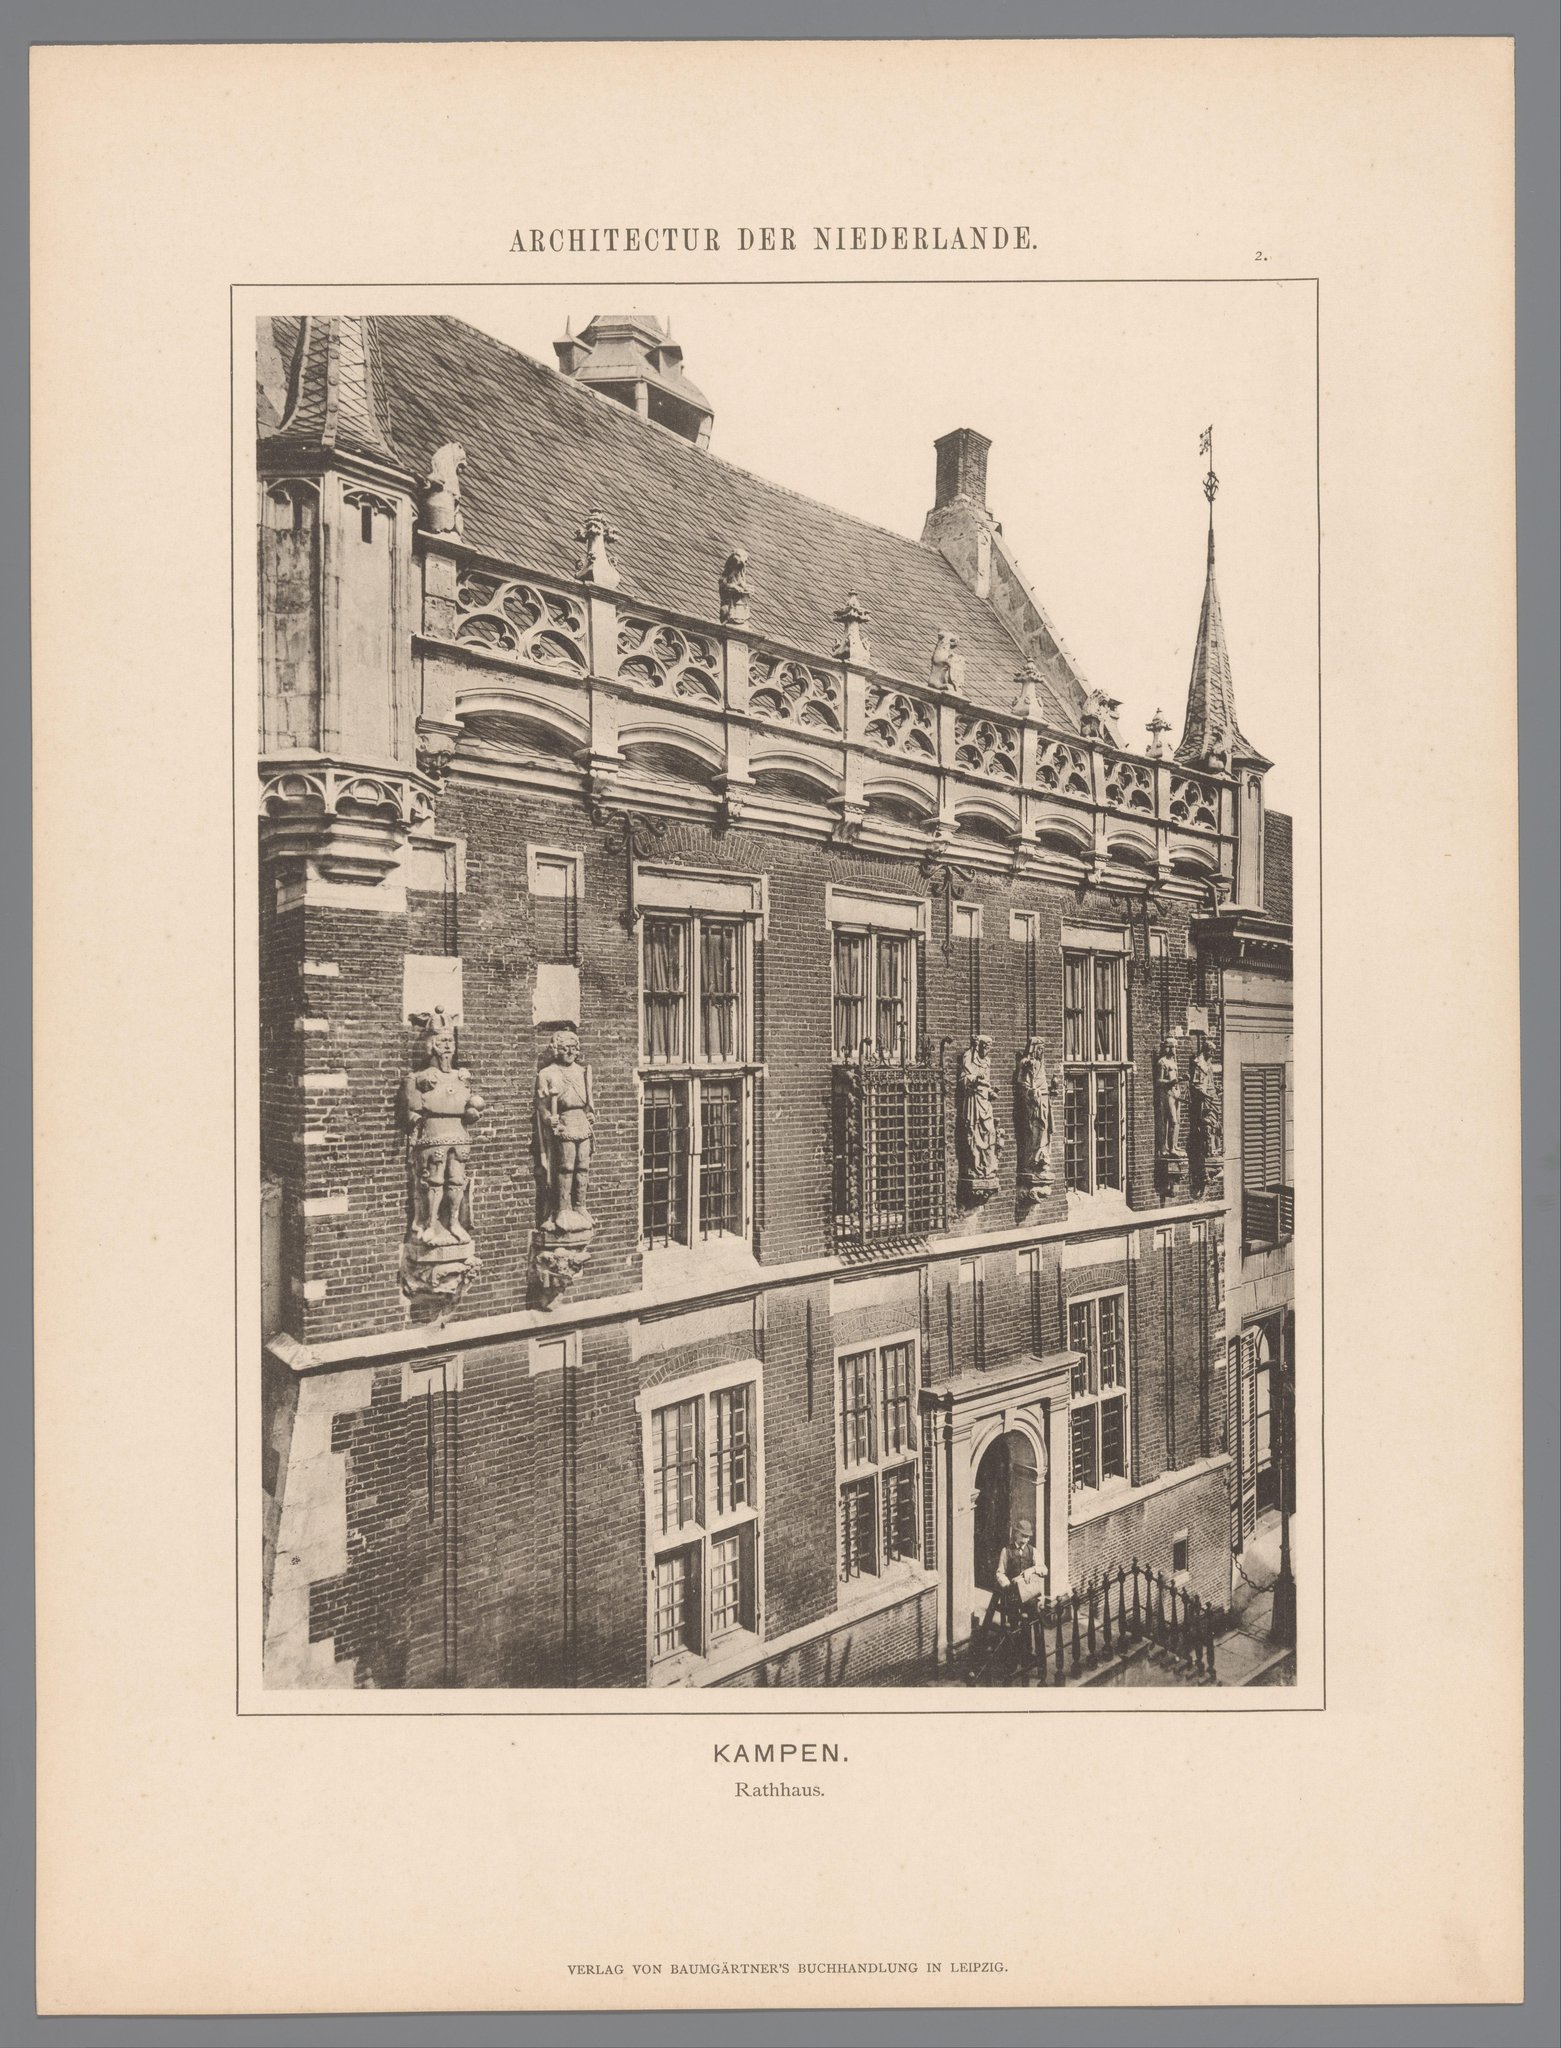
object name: photomechanical print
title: Kampen, Rathhaus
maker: Anonymous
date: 1894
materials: paper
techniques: photograph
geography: leipzig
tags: townhall, façade (of house or building)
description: Afdruk uit: Krook, L. Architectur der Niederlande. Leipzig: Baumgärtner's Buchhandlung, 1894.